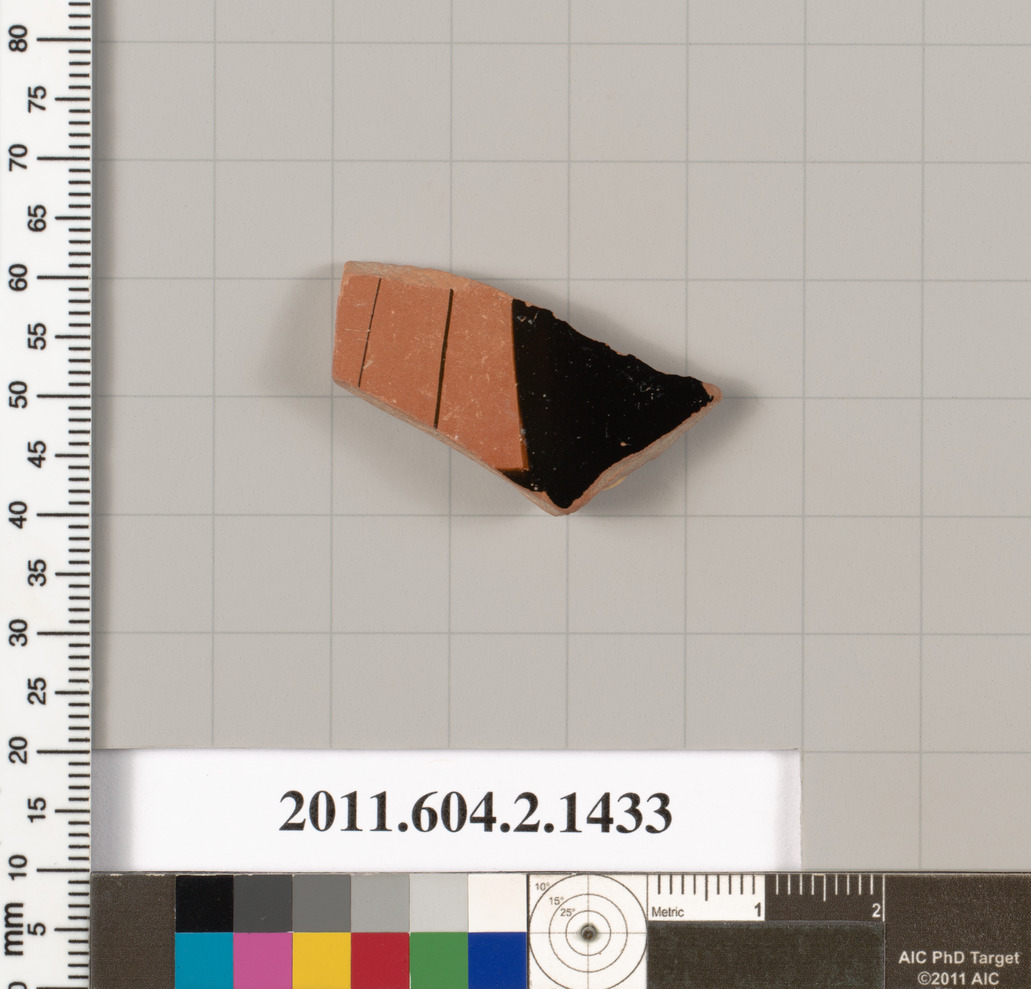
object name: skyphos fragment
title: Terracotta fragment of a skyphos (deep drinking cup)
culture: greek, attic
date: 475-451 BCE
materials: terracotta